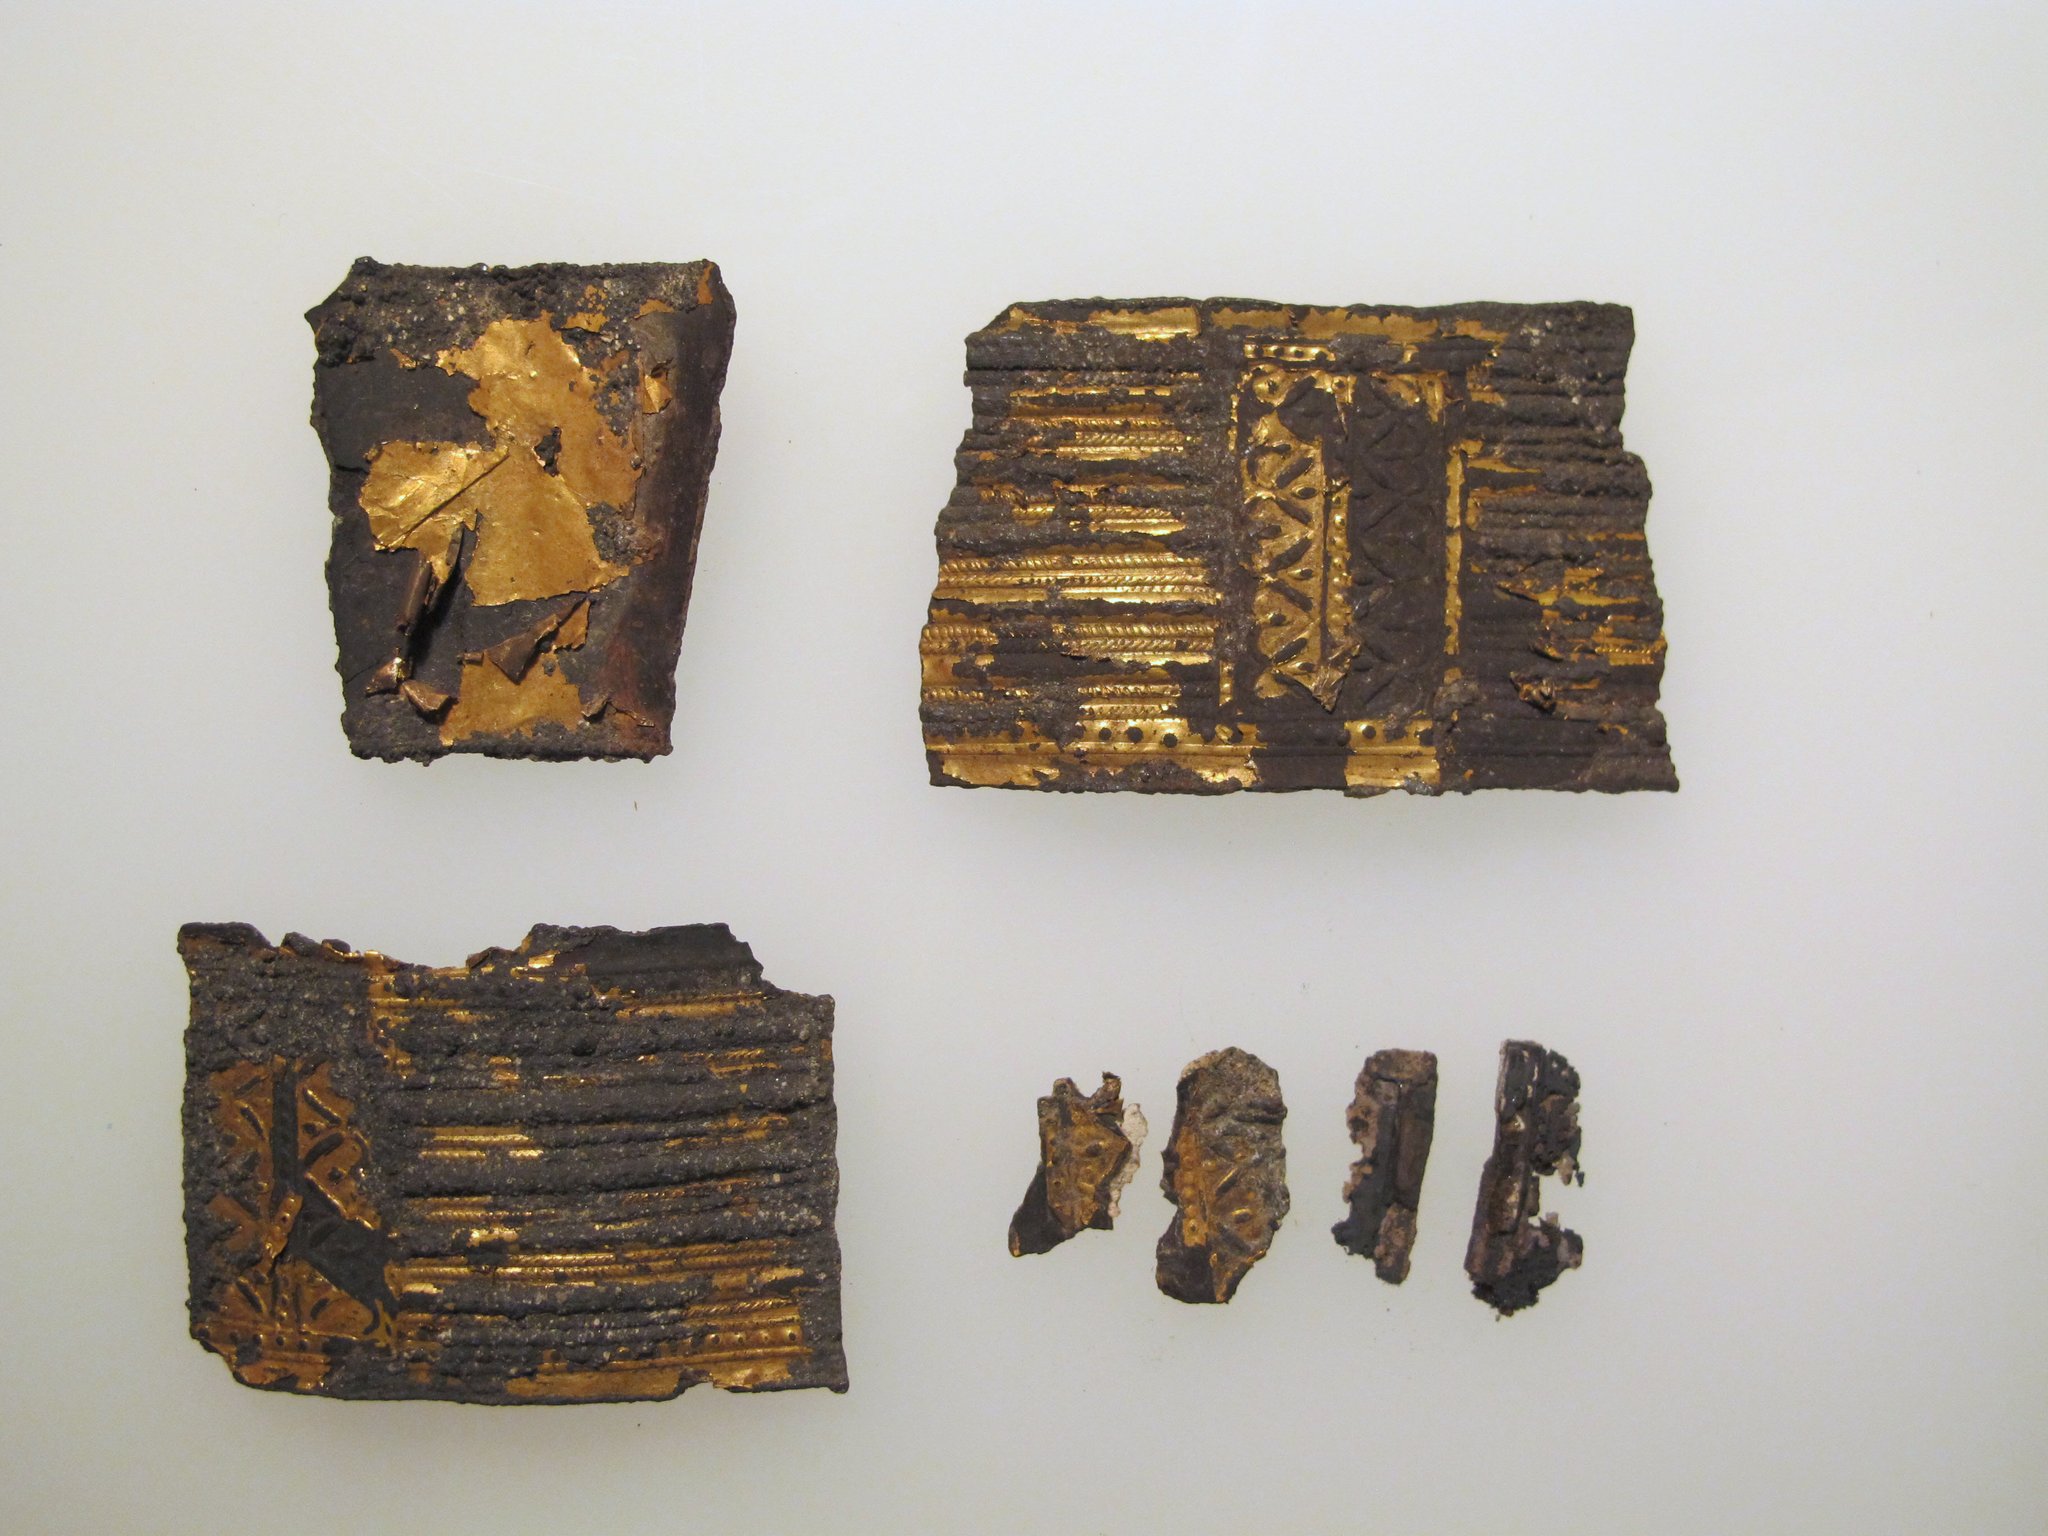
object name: bracelet fragment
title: Silver bracelet fragments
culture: cypriot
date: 3900 BCE-100 CE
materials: silver